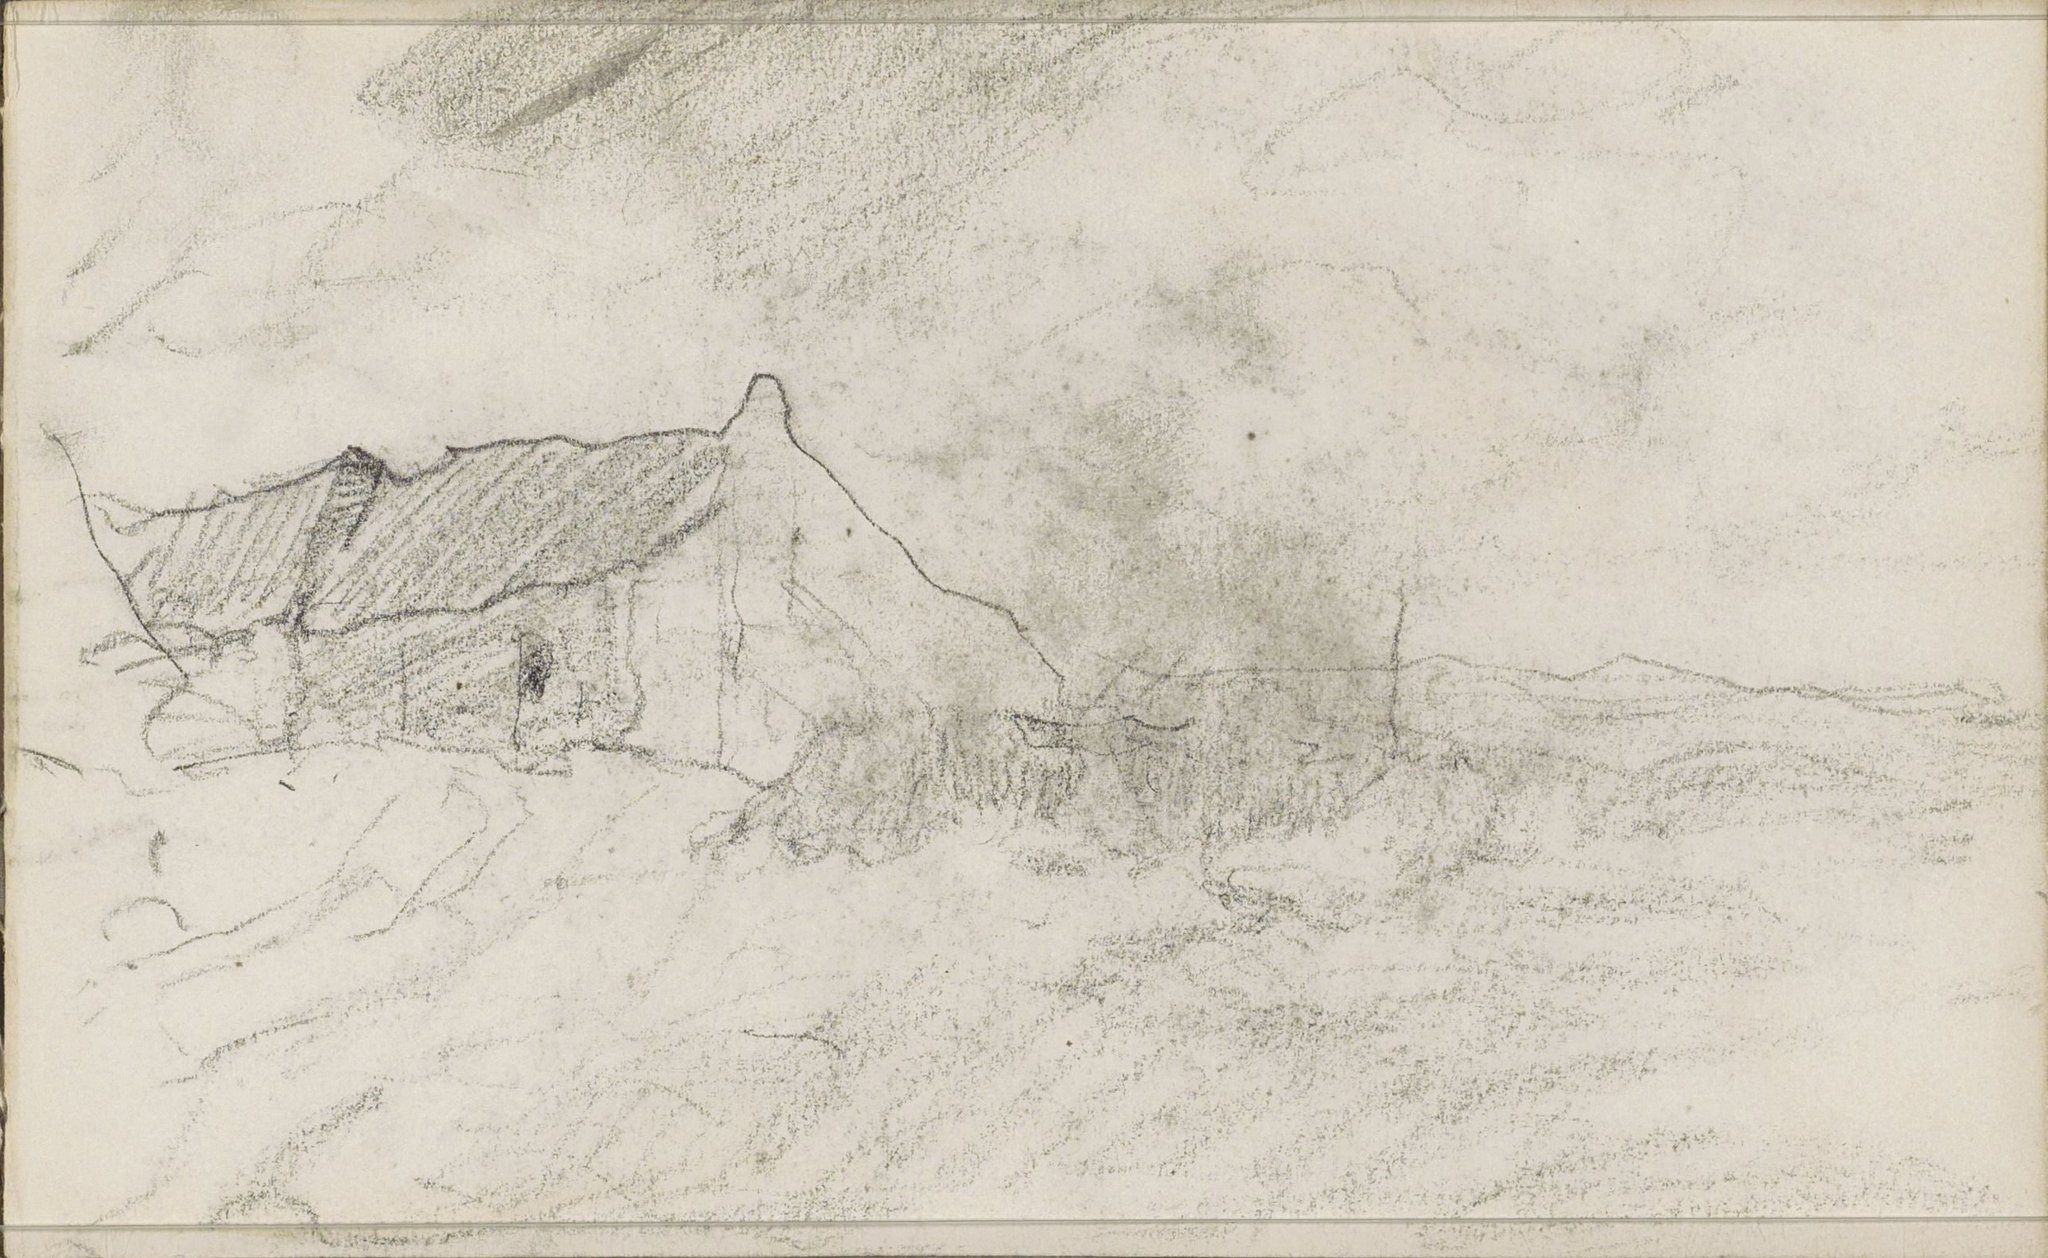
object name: sketchbook leaf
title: Landschap met een boerderij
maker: anton mauve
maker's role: draughtsman, painter, print maker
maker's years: 1838-1888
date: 1848-1888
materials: chalk, paper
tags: farm or solitary house in landscape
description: Blad 15 recto uit een schetsboek met 41 bladen.